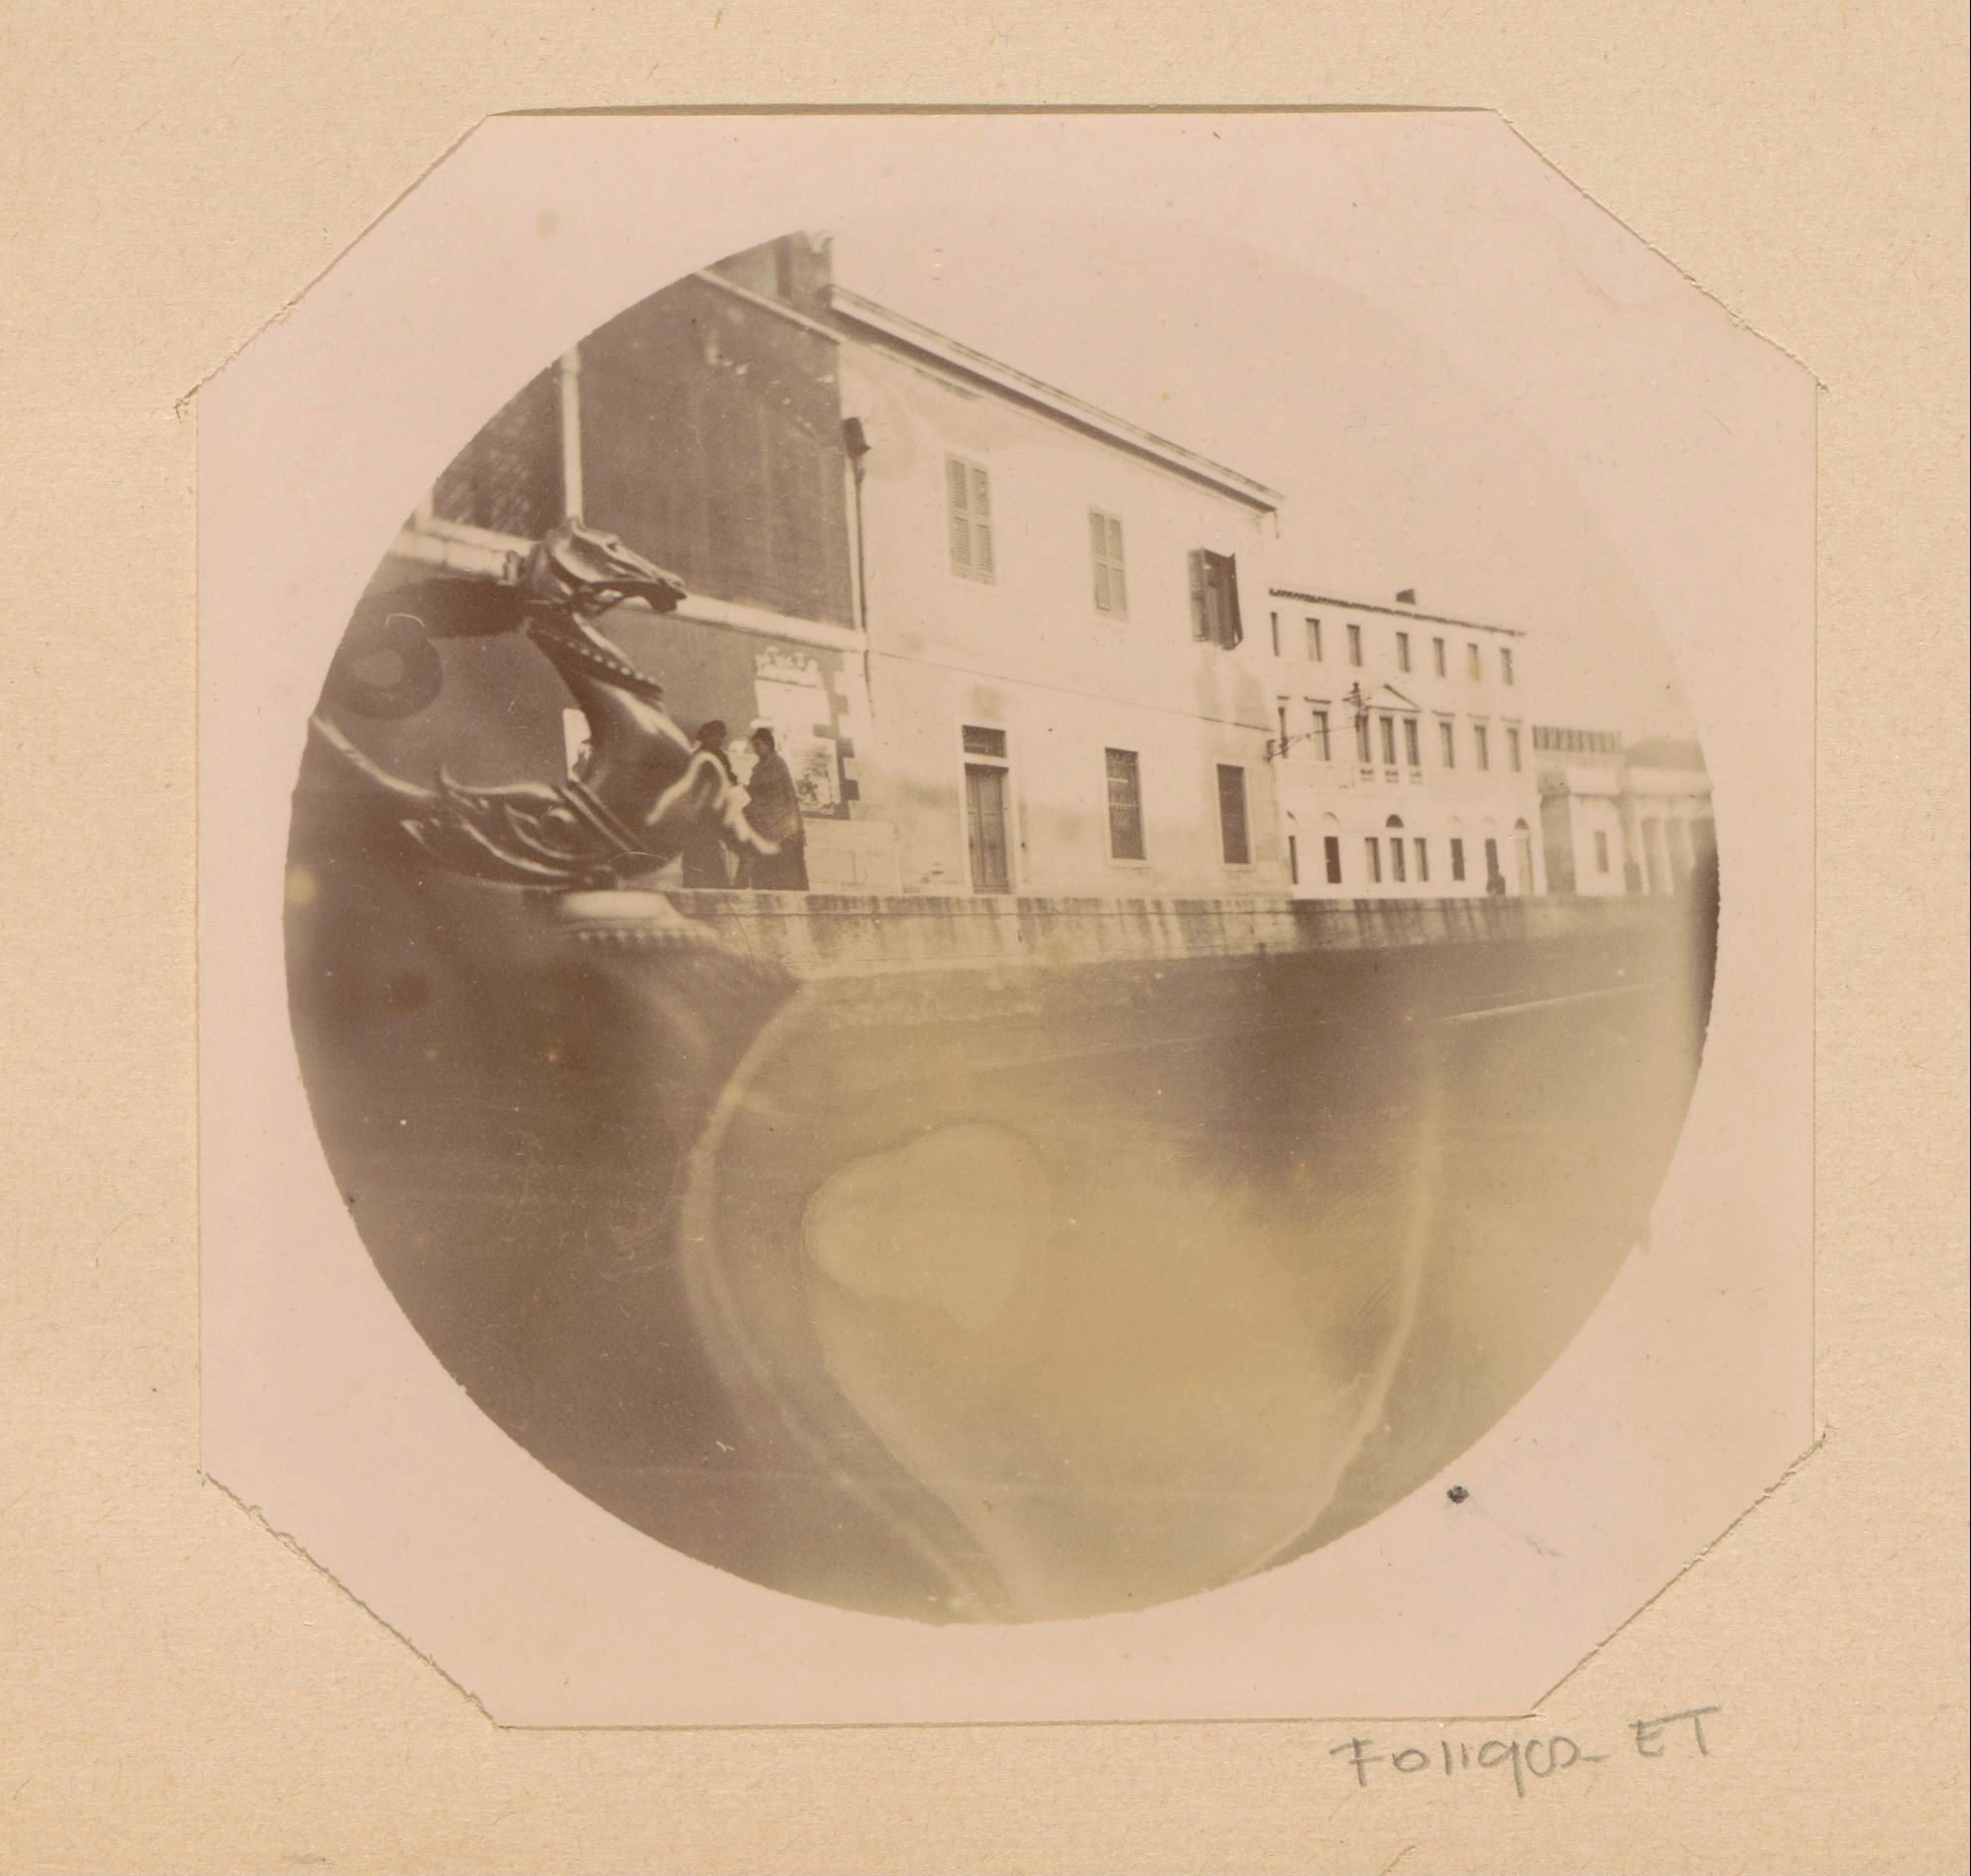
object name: photograph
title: Venetië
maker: johanna margaretha piek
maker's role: fotograaf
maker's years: 1870-1947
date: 1889-1893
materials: paper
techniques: gelatin silver print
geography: venice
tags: gondola, venice